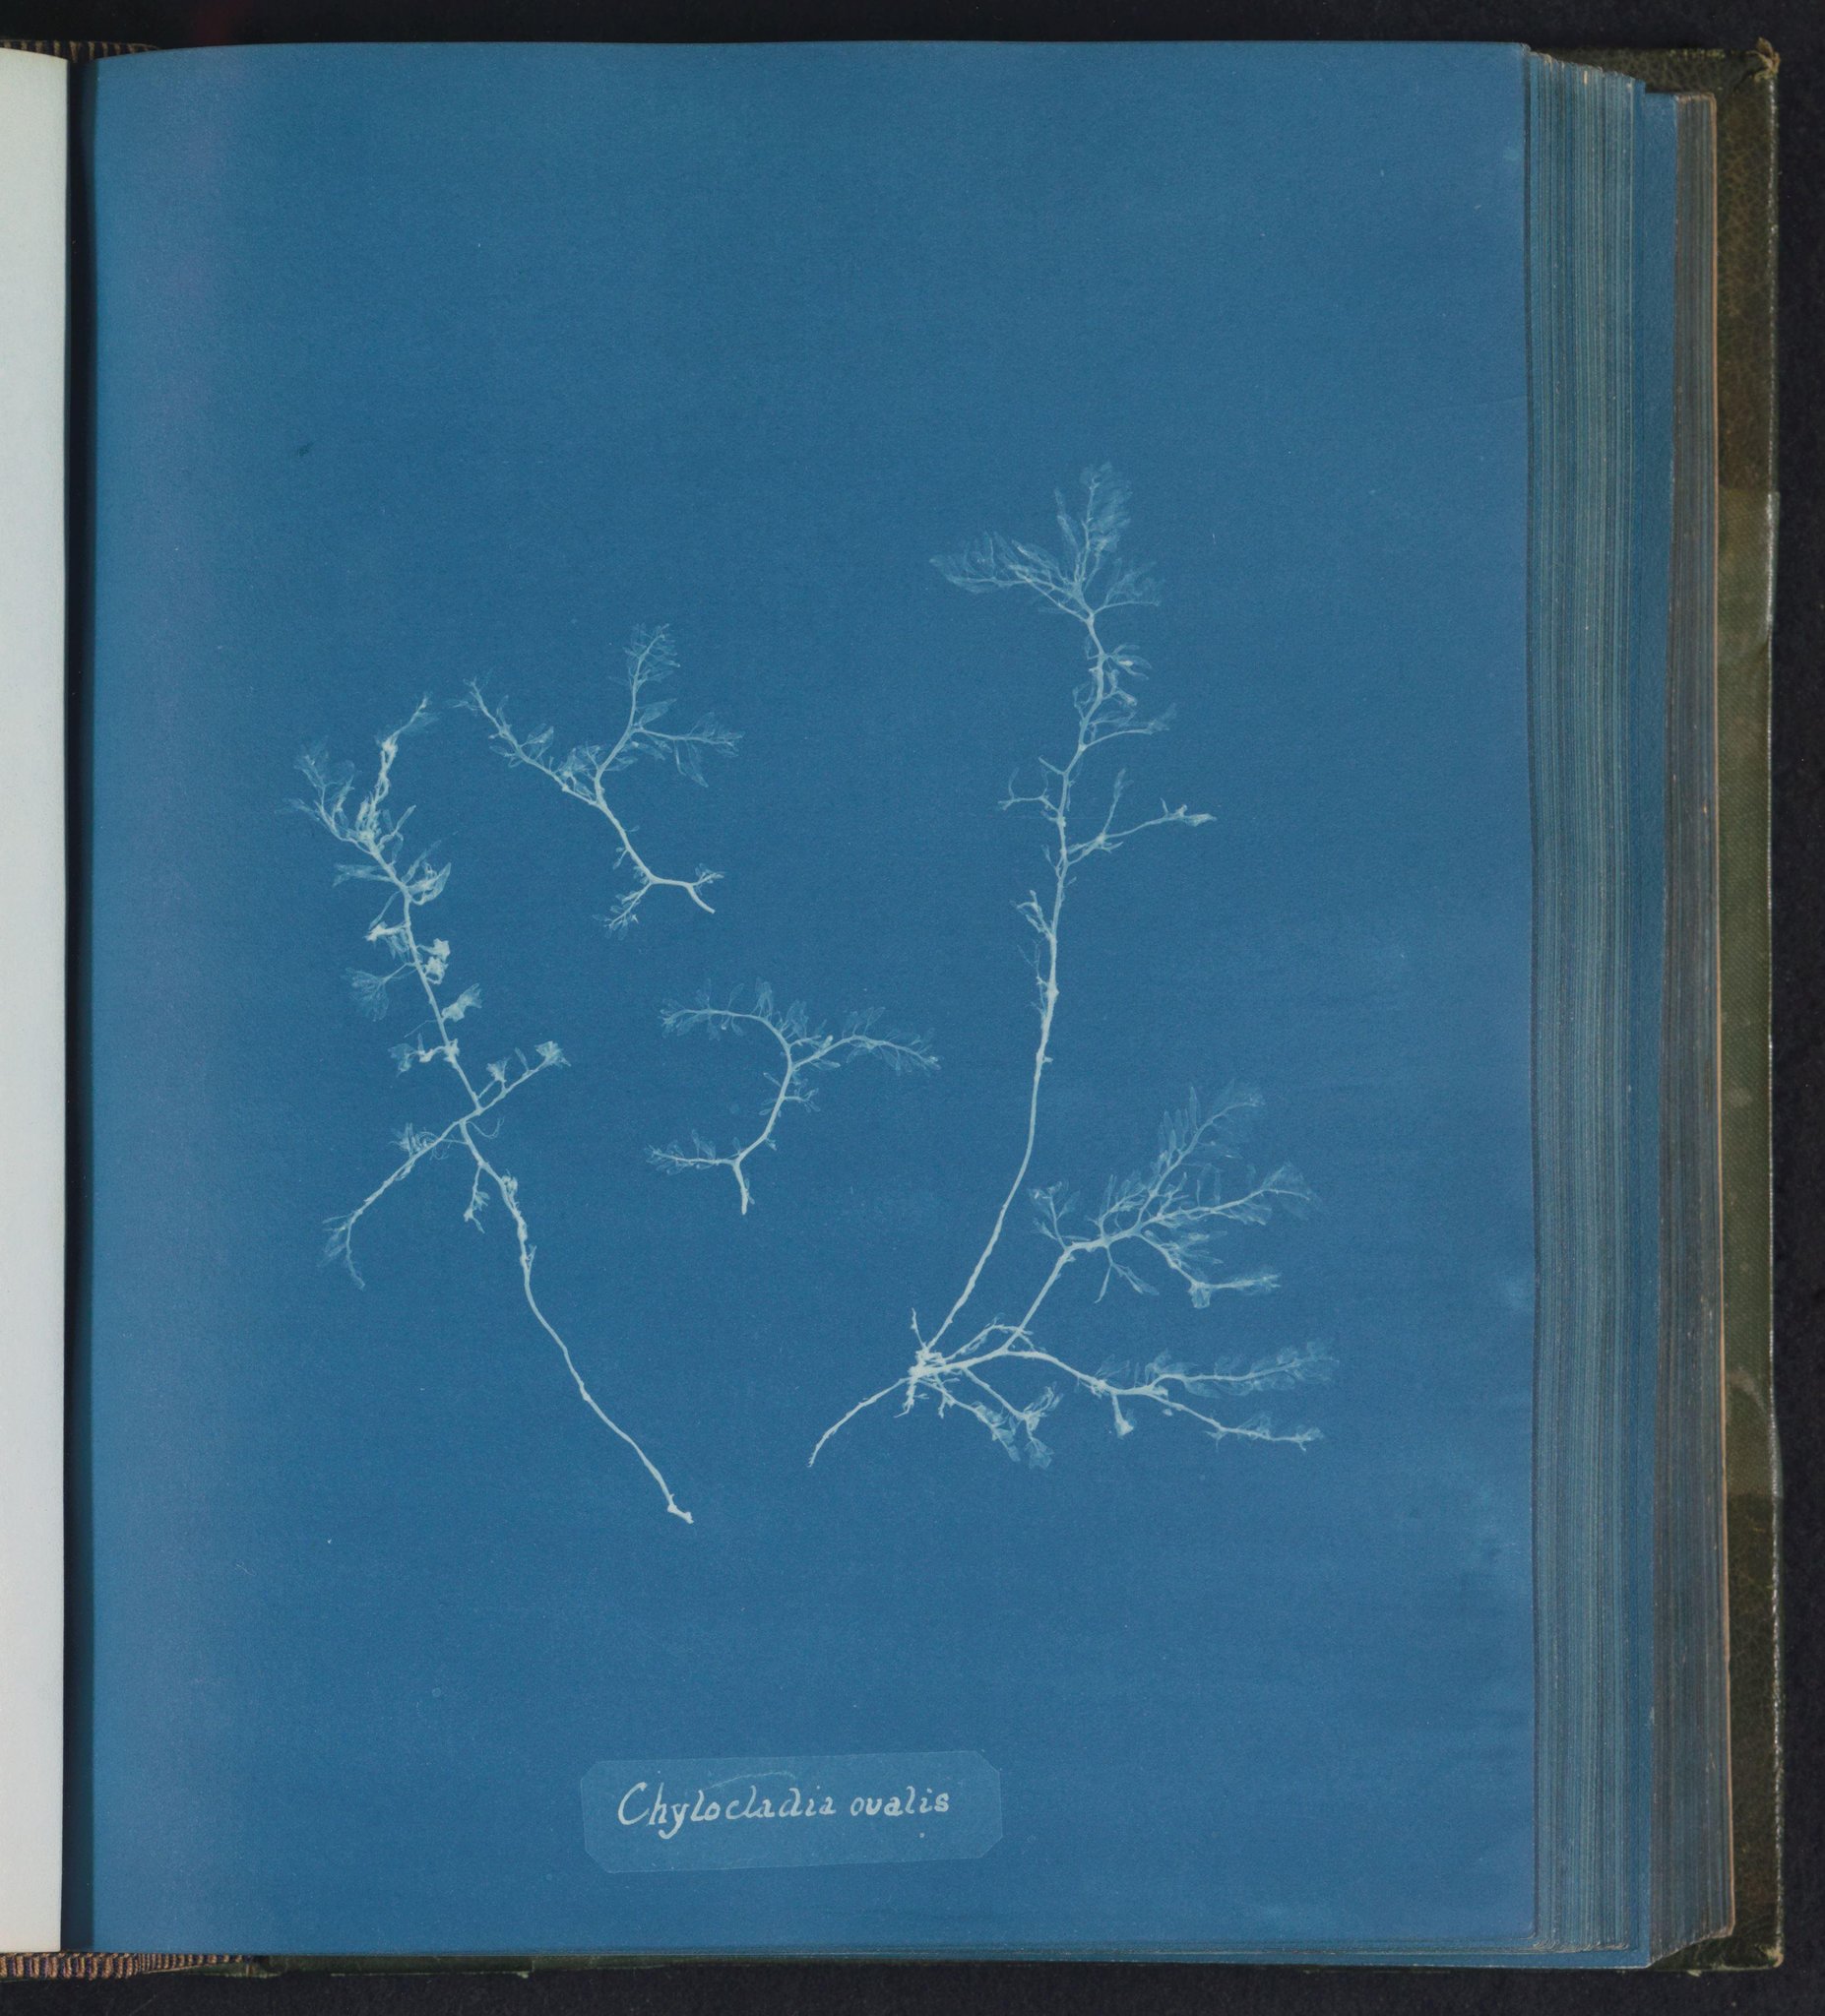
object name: photograph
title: Chylocladia ovalis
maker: anna atkins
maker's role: fotograaf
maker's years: 1799-1871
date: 1843-1853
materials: photographic support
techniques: cyanotype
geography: united kingdom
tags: algae, seaweed